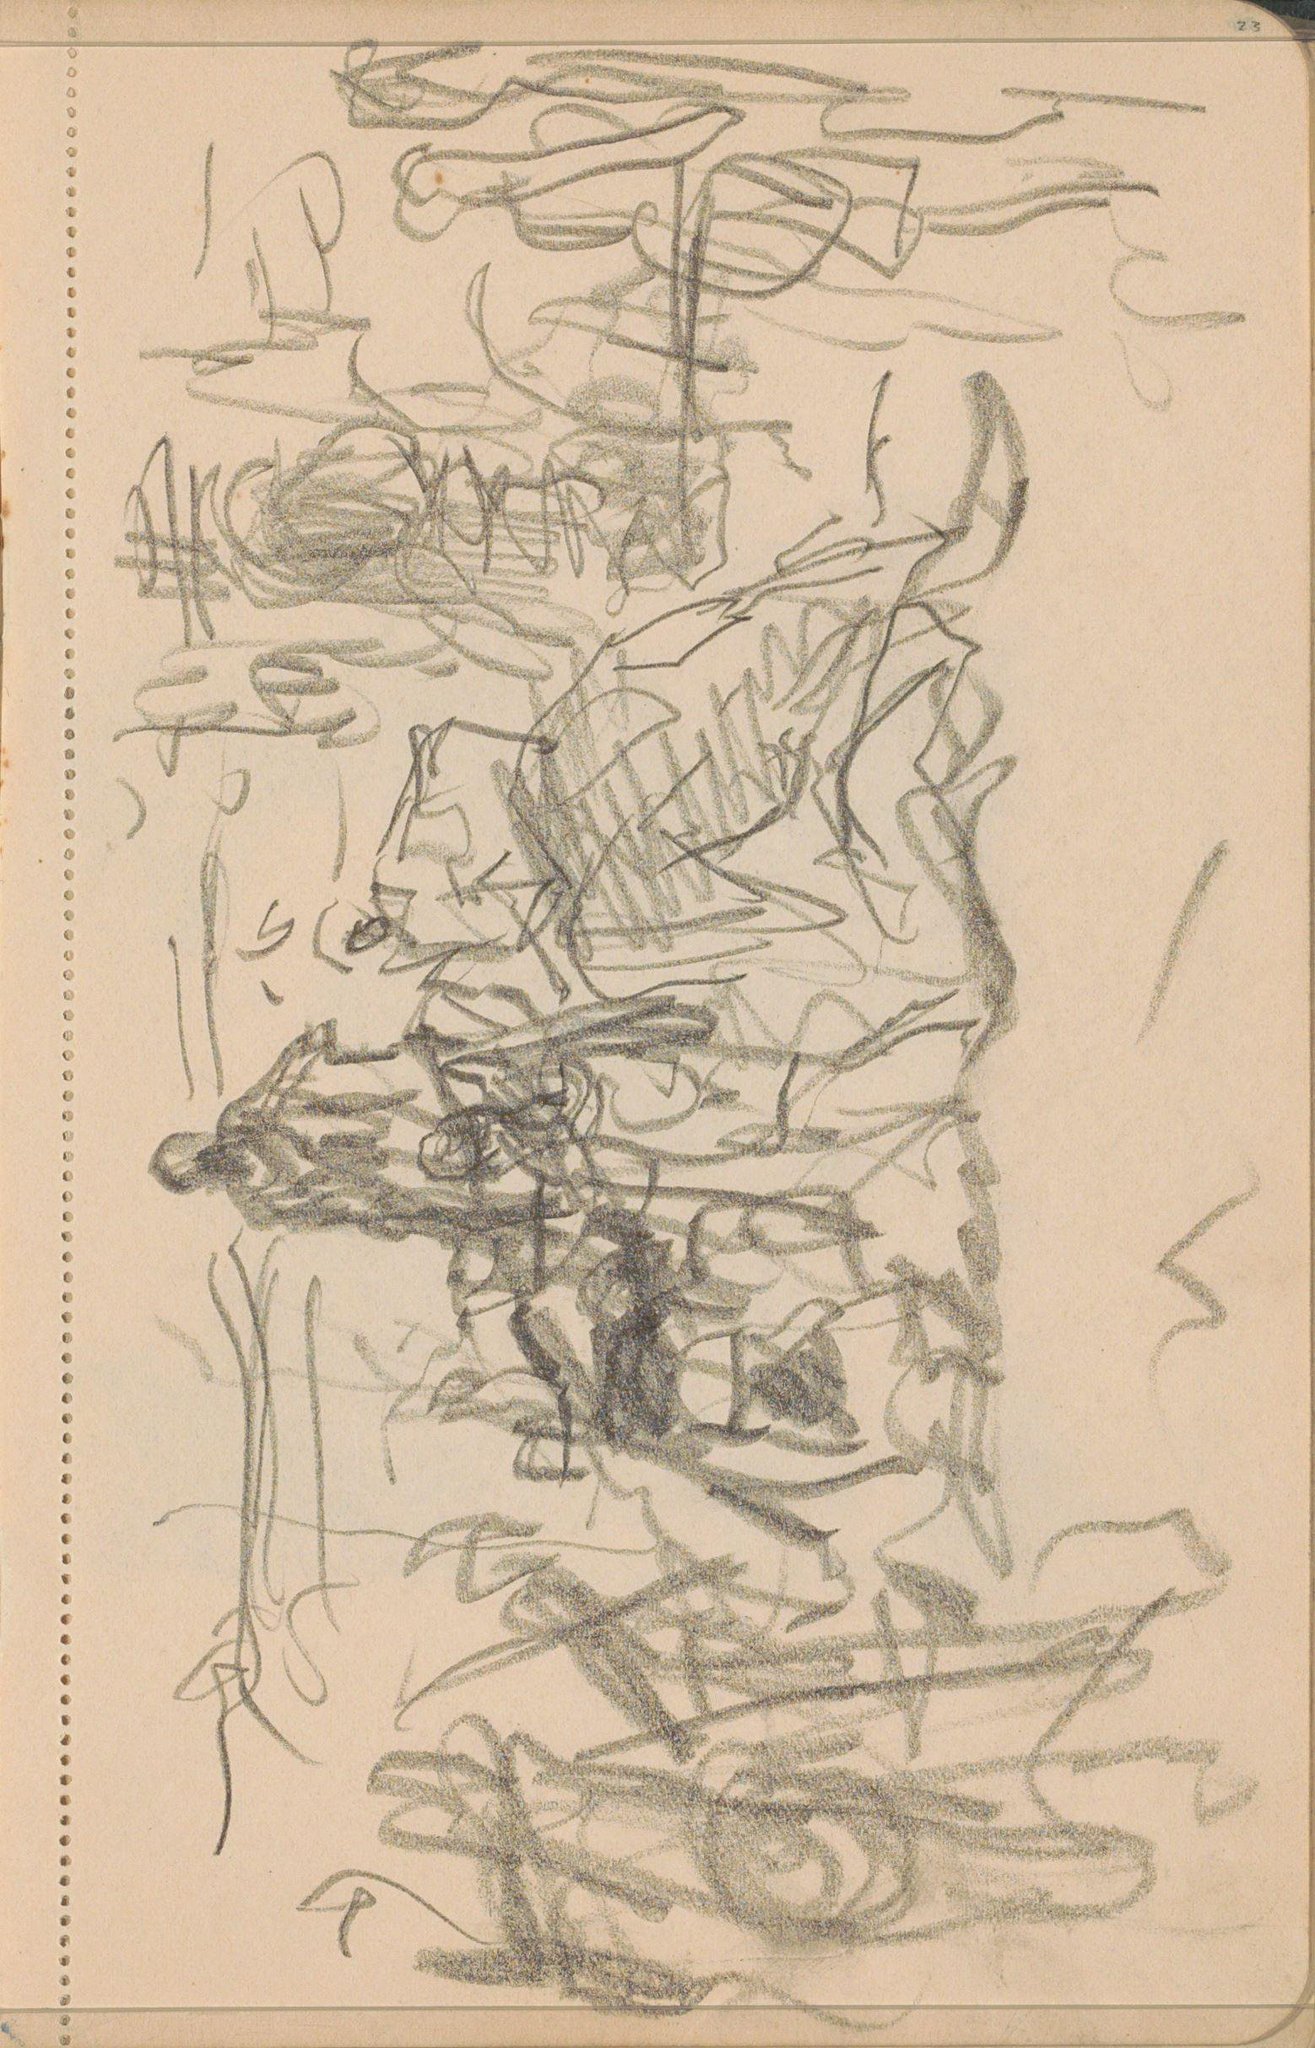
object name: sketchbook leaf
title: Straat met figuren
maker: marius bauer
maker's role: draughtsman, print maker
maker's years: 1867-1932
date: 1924-1925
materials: paper, pencil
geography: india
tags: street (+ city(-scape) with figures, staffage)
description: Mogelijk staan en zitten enkele van de figuren op een olifant. Pagina 23 uit een schetsboek met 87 bladen.